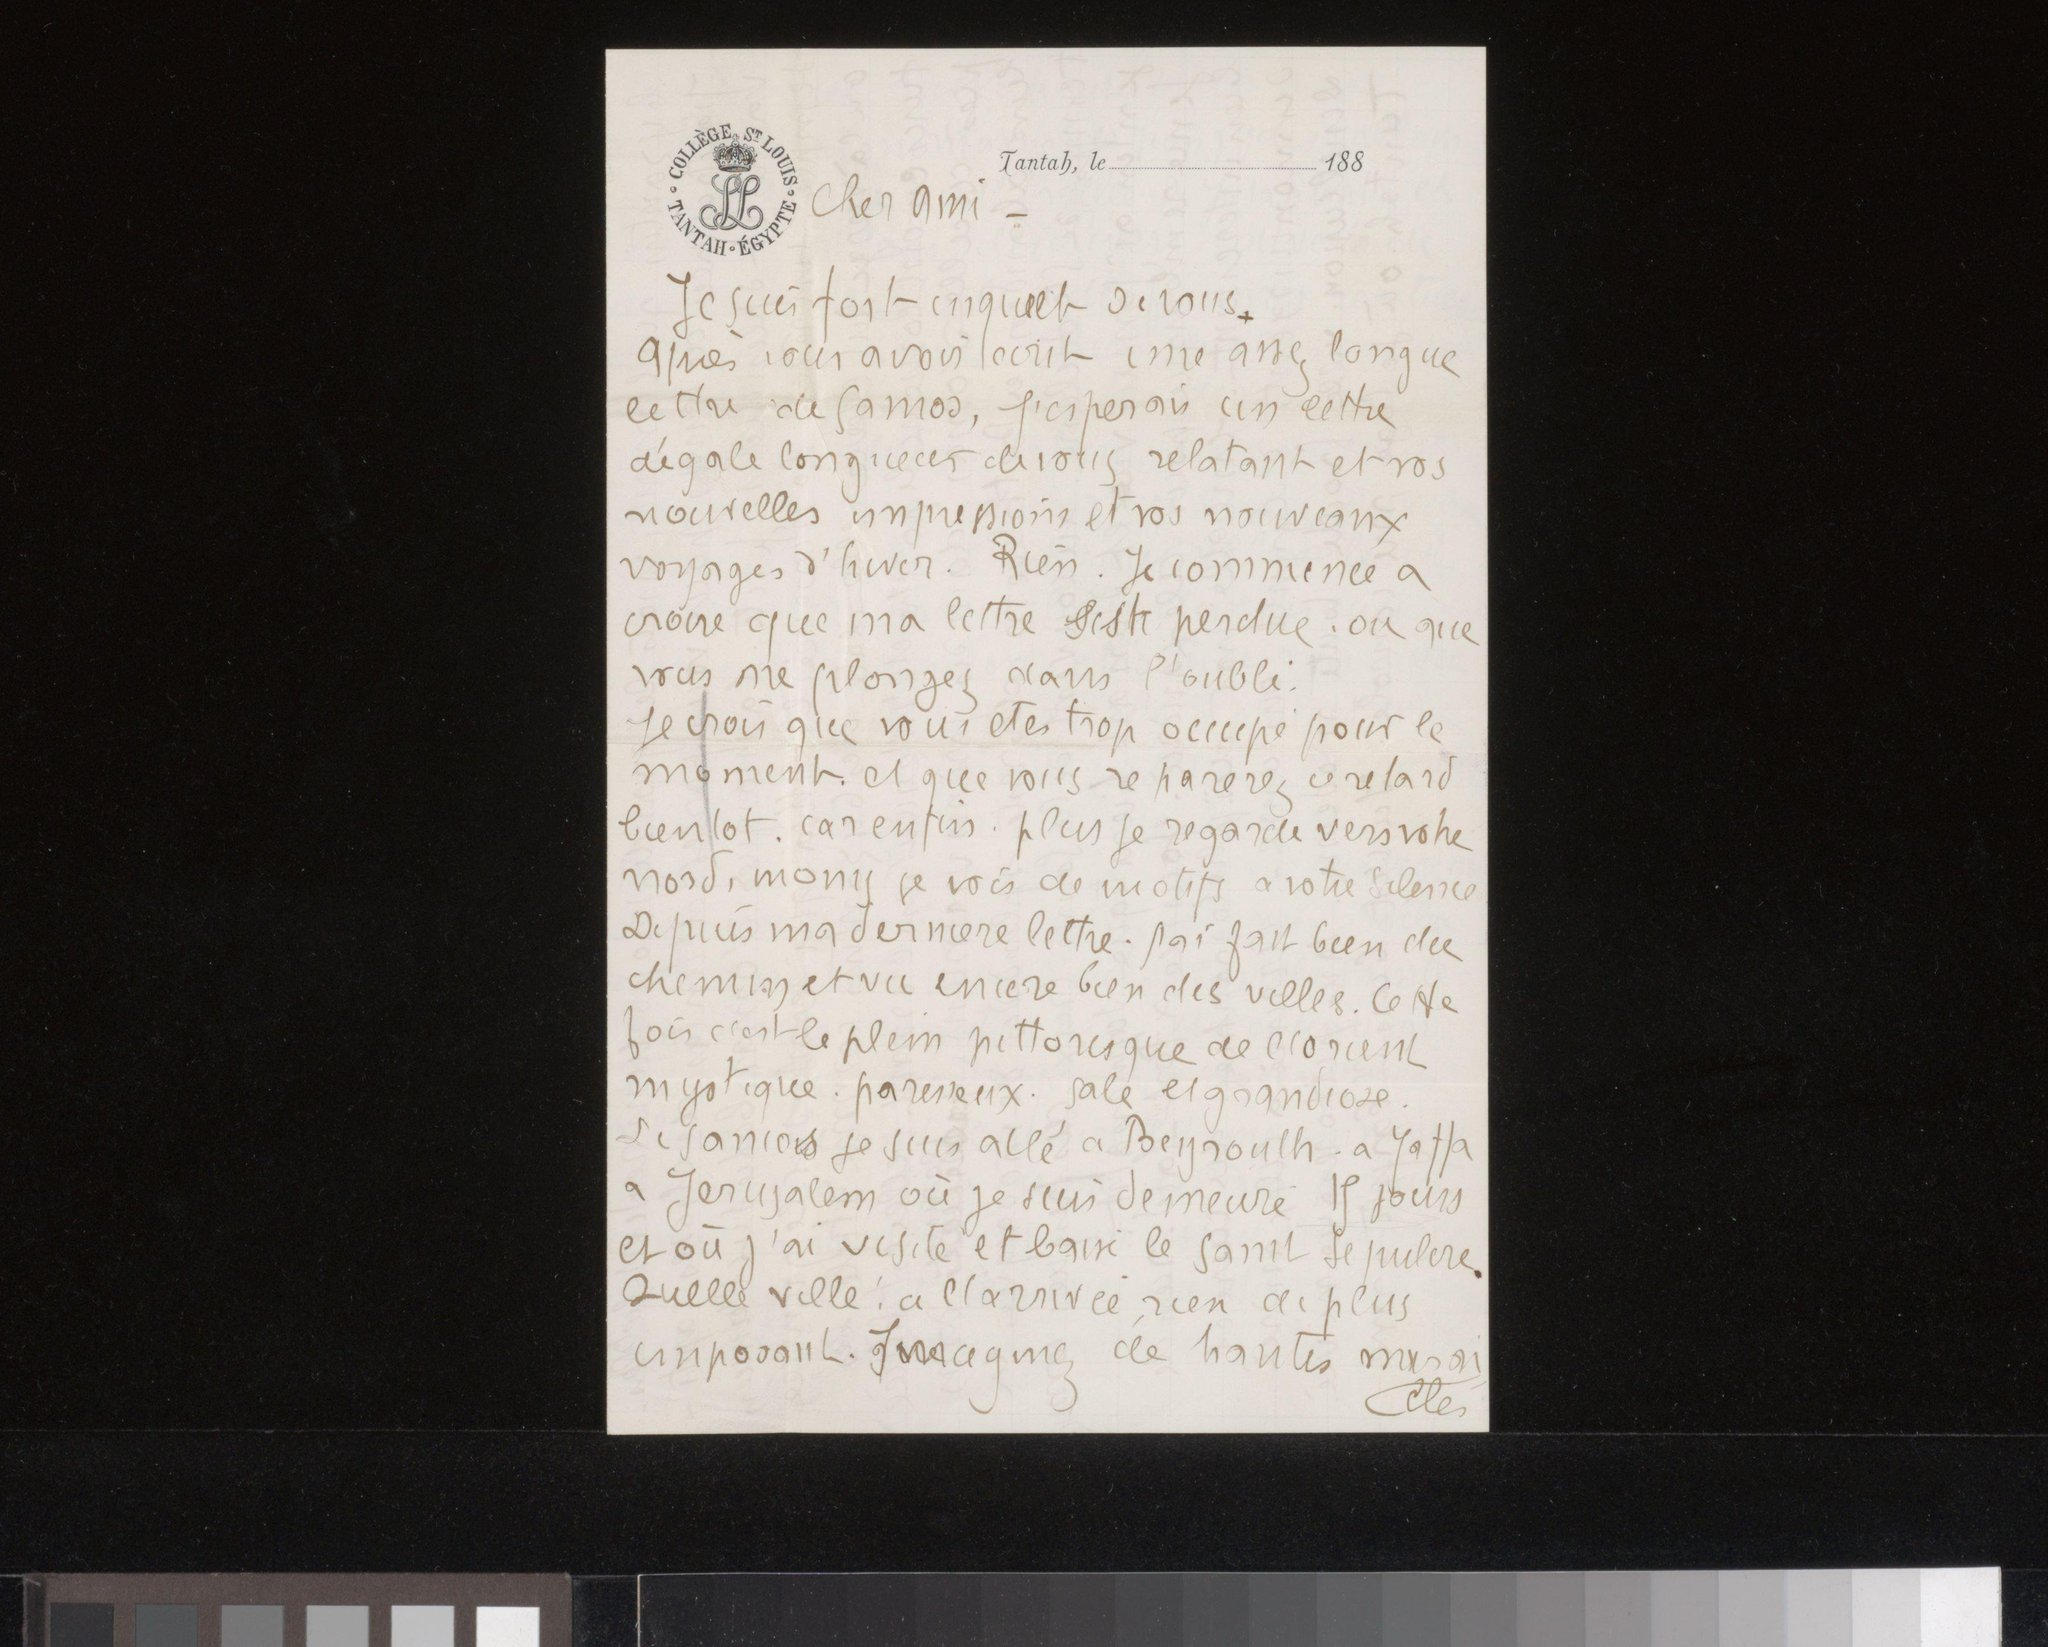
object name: letter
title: Brief aan Andries Bonger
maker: émile bernard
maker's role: print maker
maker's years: 1868-1941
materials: ink, paper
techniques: pen, printing, writing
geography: ṭanṭā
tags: painter, print maker, draughtsman, rembrandt van rijn, amsterdam, andries bonger, travelling; tourism, architecture